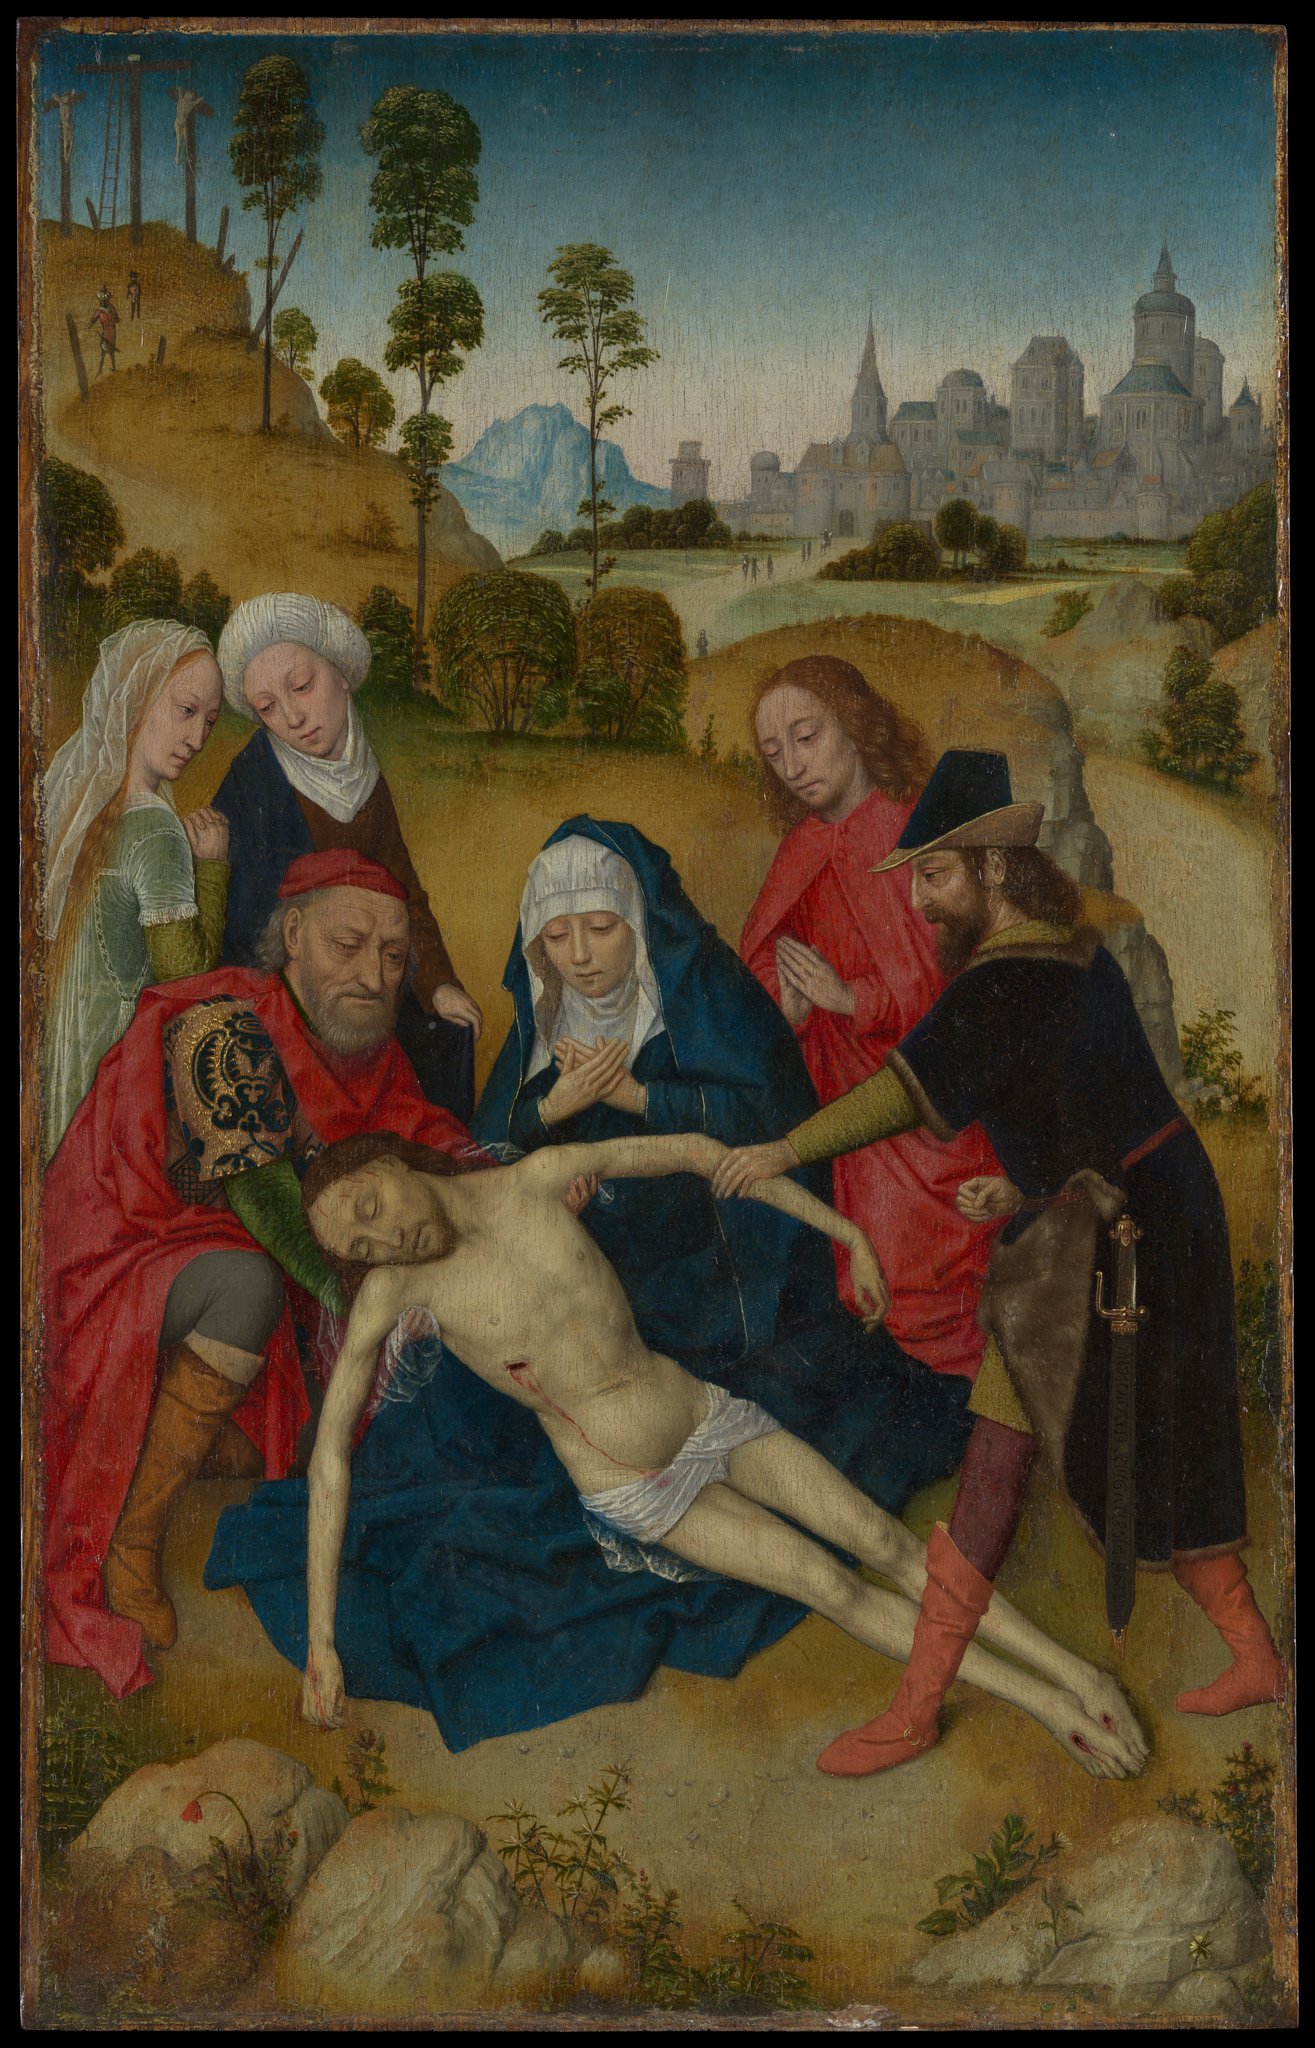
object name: painting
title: The Lamentation of Christ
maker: simon marmion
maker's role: artist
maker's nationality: french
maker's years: 1425-1489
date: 1473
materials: wood, oil, panel, paint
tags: men,women,christ,virgin mary,lamentation